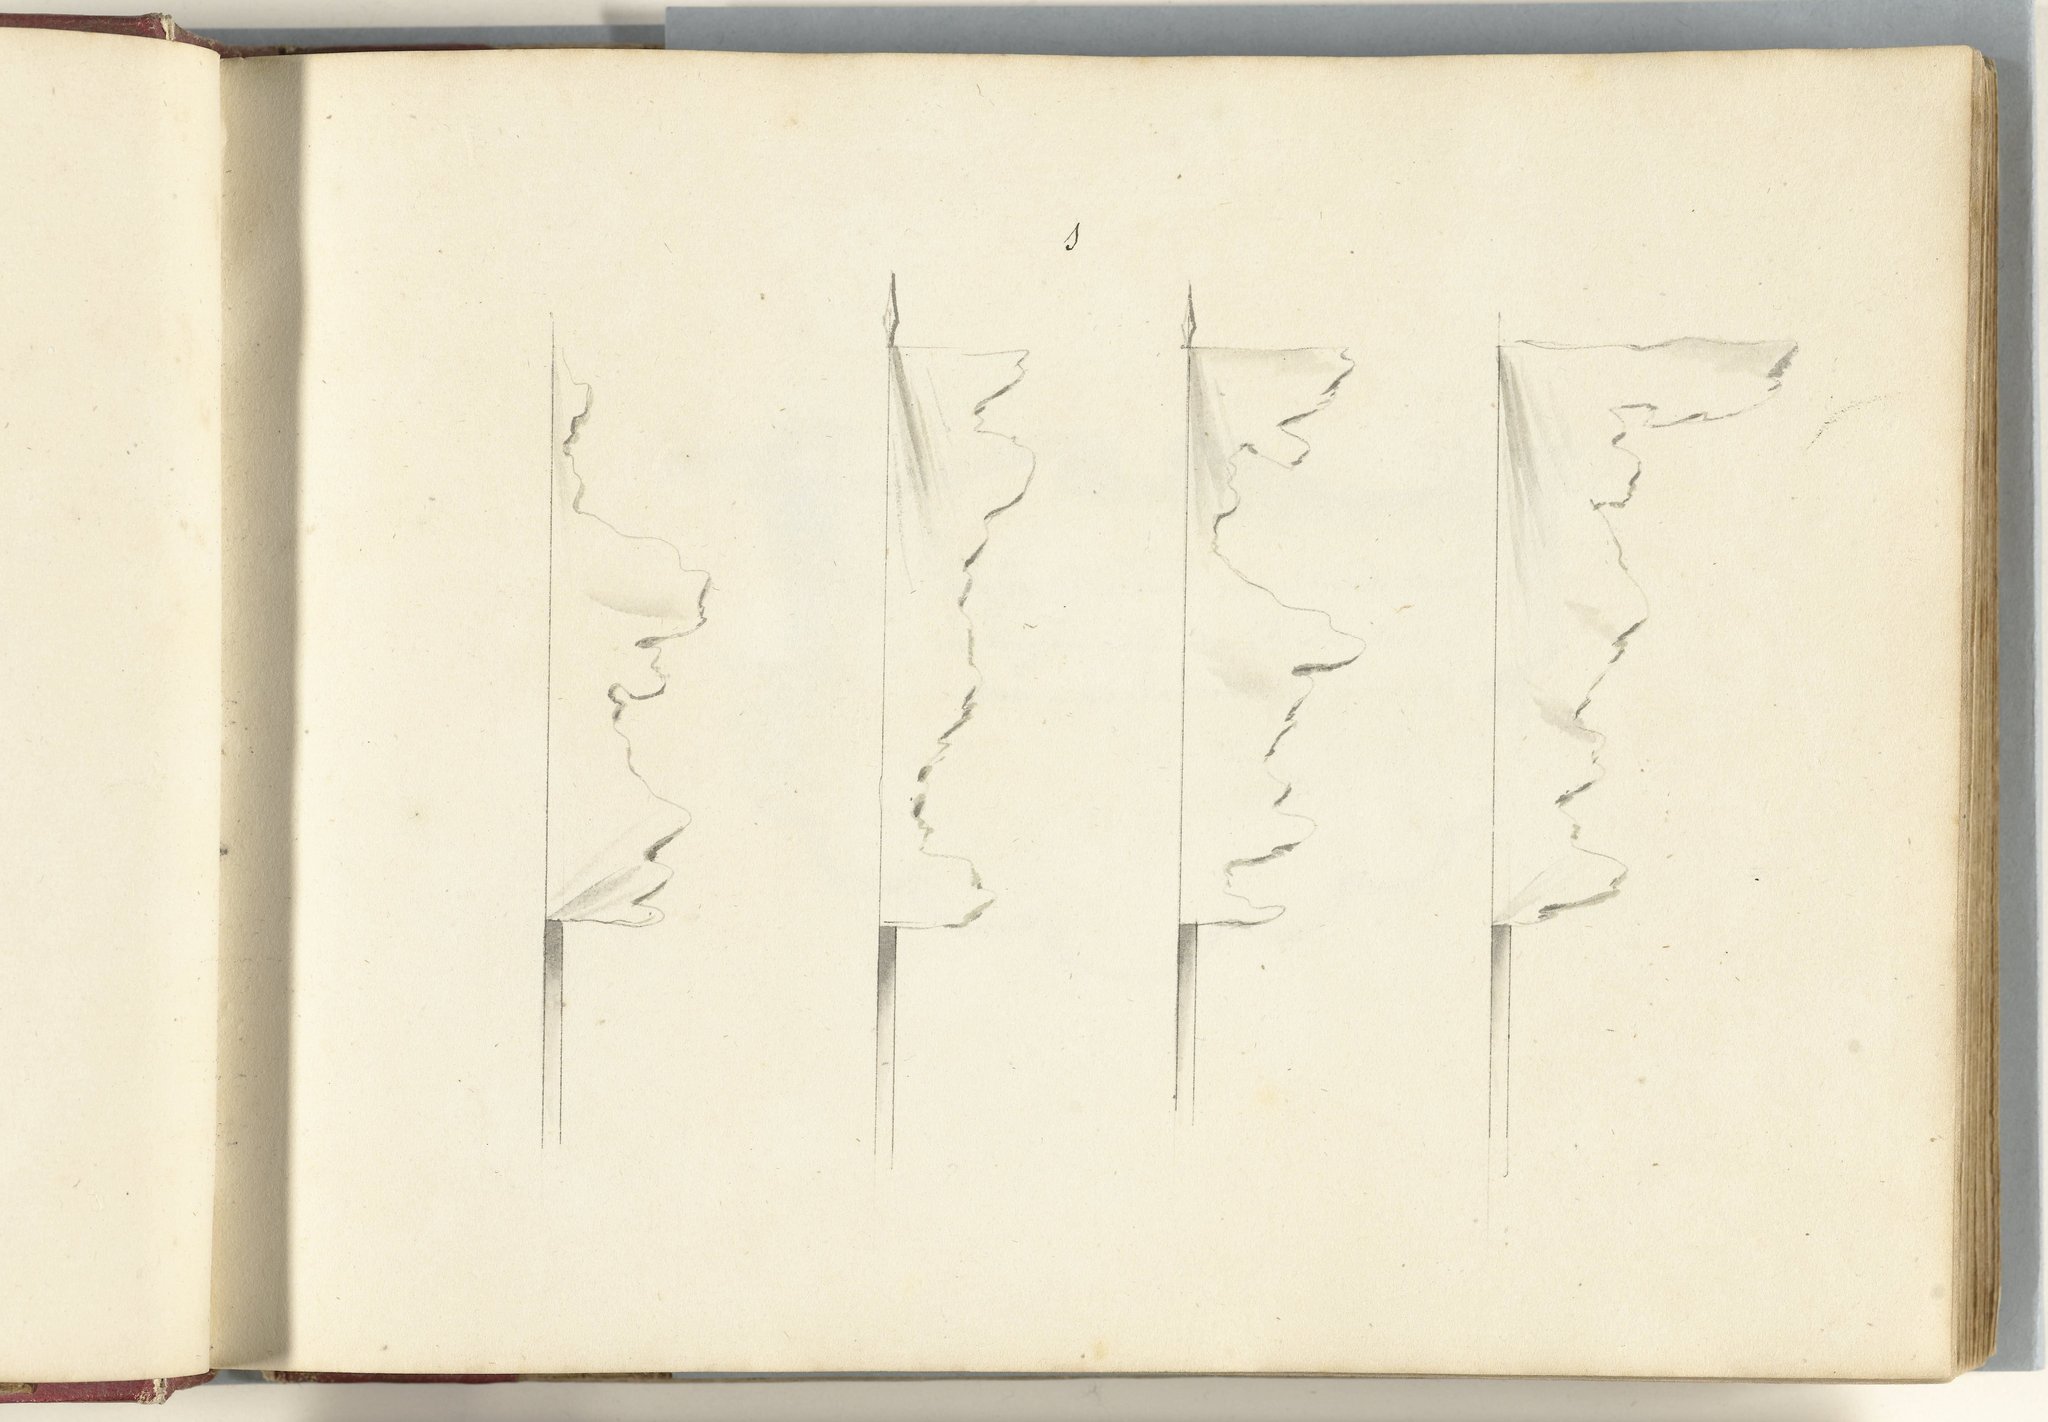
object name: drawing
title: Vier Franse vaandels in flarden veroverd in de slag bij Spierbach, 1703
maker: Anonymous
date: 1713-1720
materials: paper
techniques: drawing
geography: northern netherlands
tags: (military) flags and standards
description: Vier Franse vaandels in flarden veroverd in de slag bij Spierbach, 1703. In het boek met tekeningen van Franse vaandels, standaarden en pauken, veroverd tijdens de Spaanse Successieoorlog (1701-1713).